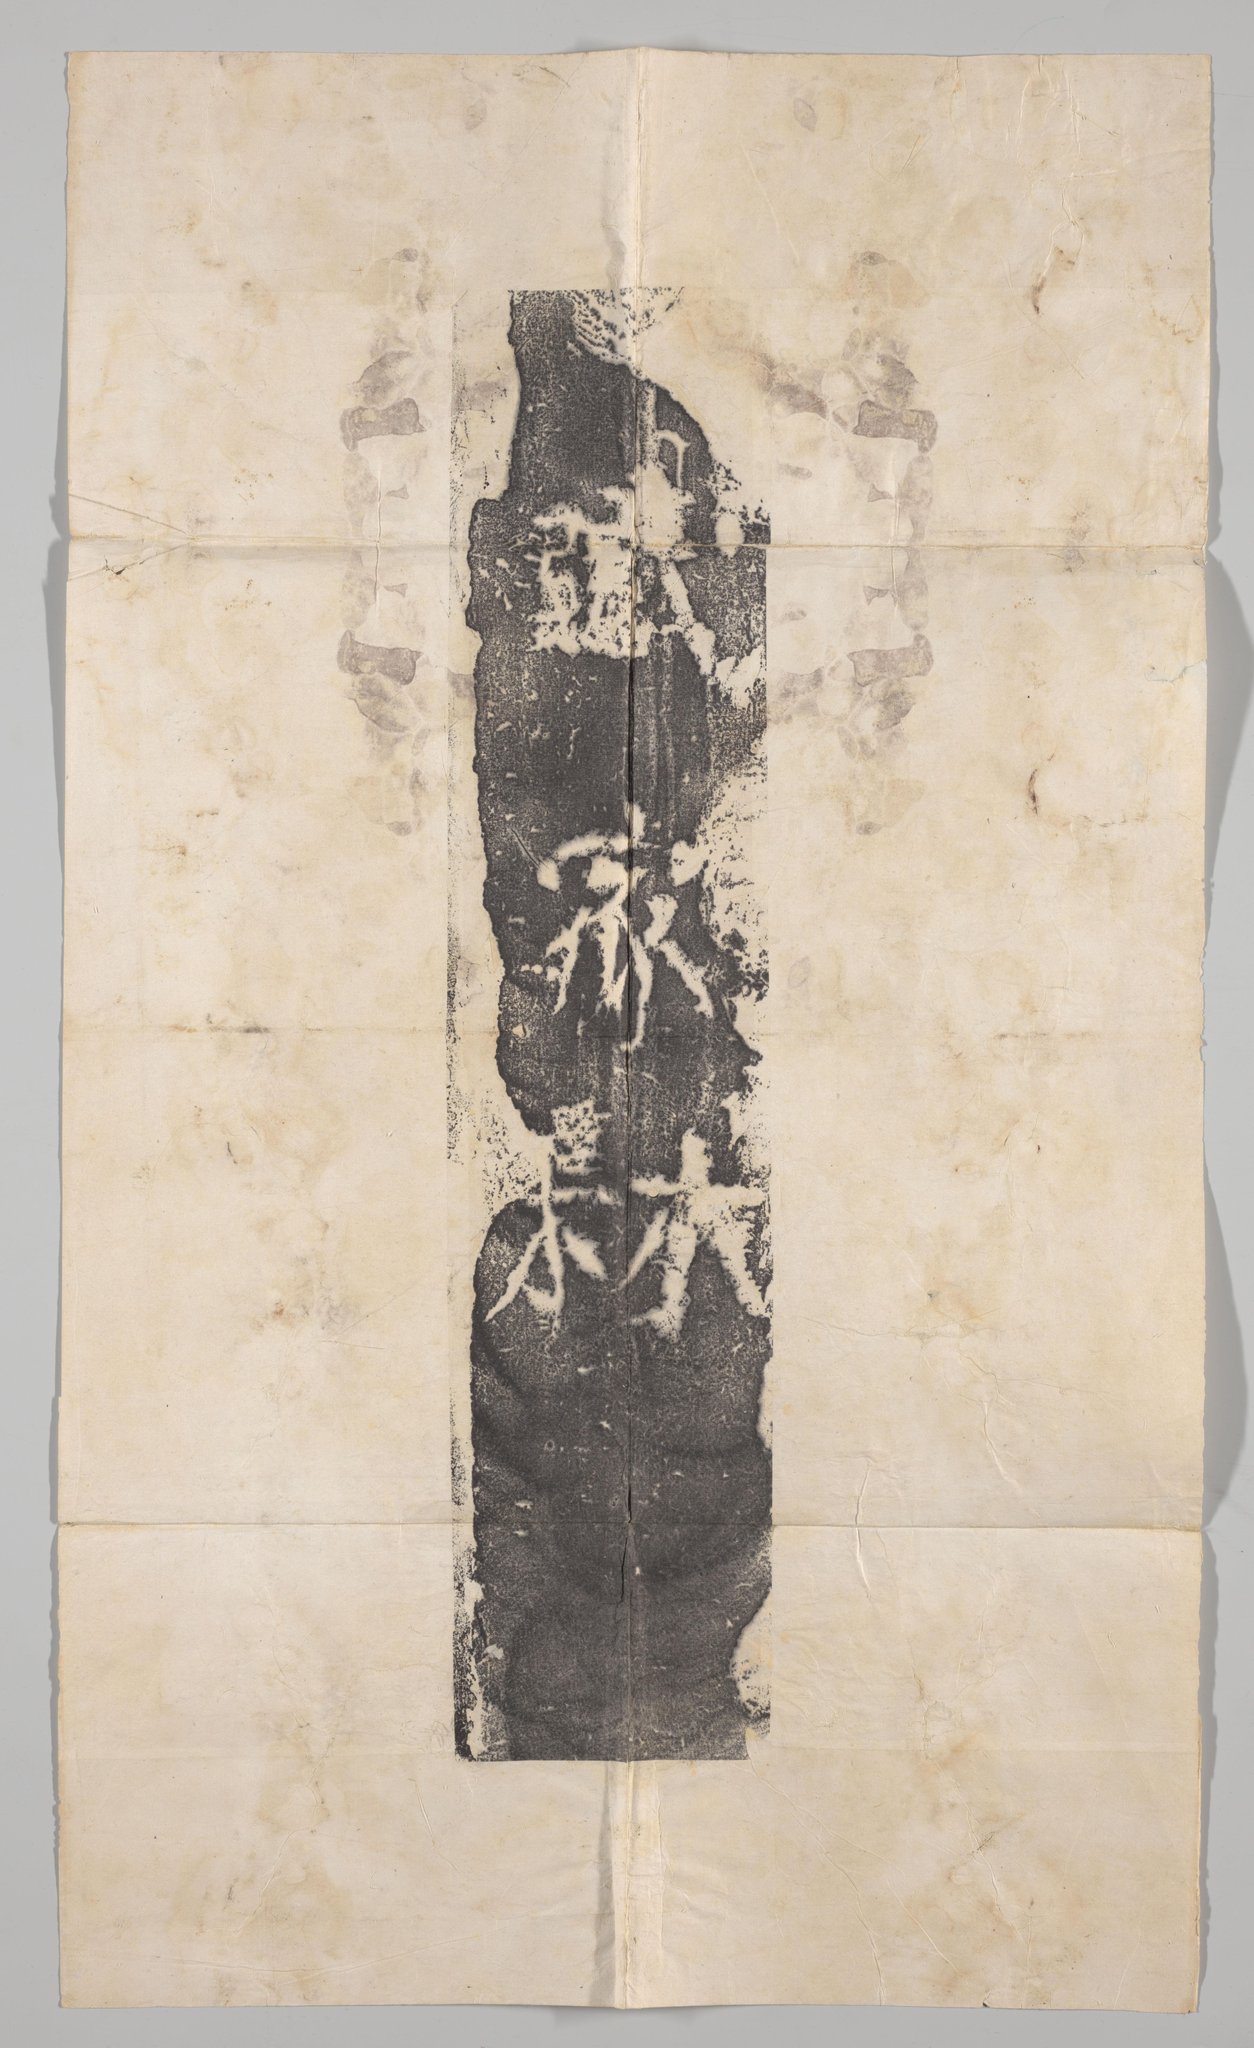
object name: wrijfprent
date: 1900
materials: ink, paper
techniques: rubbing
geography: china